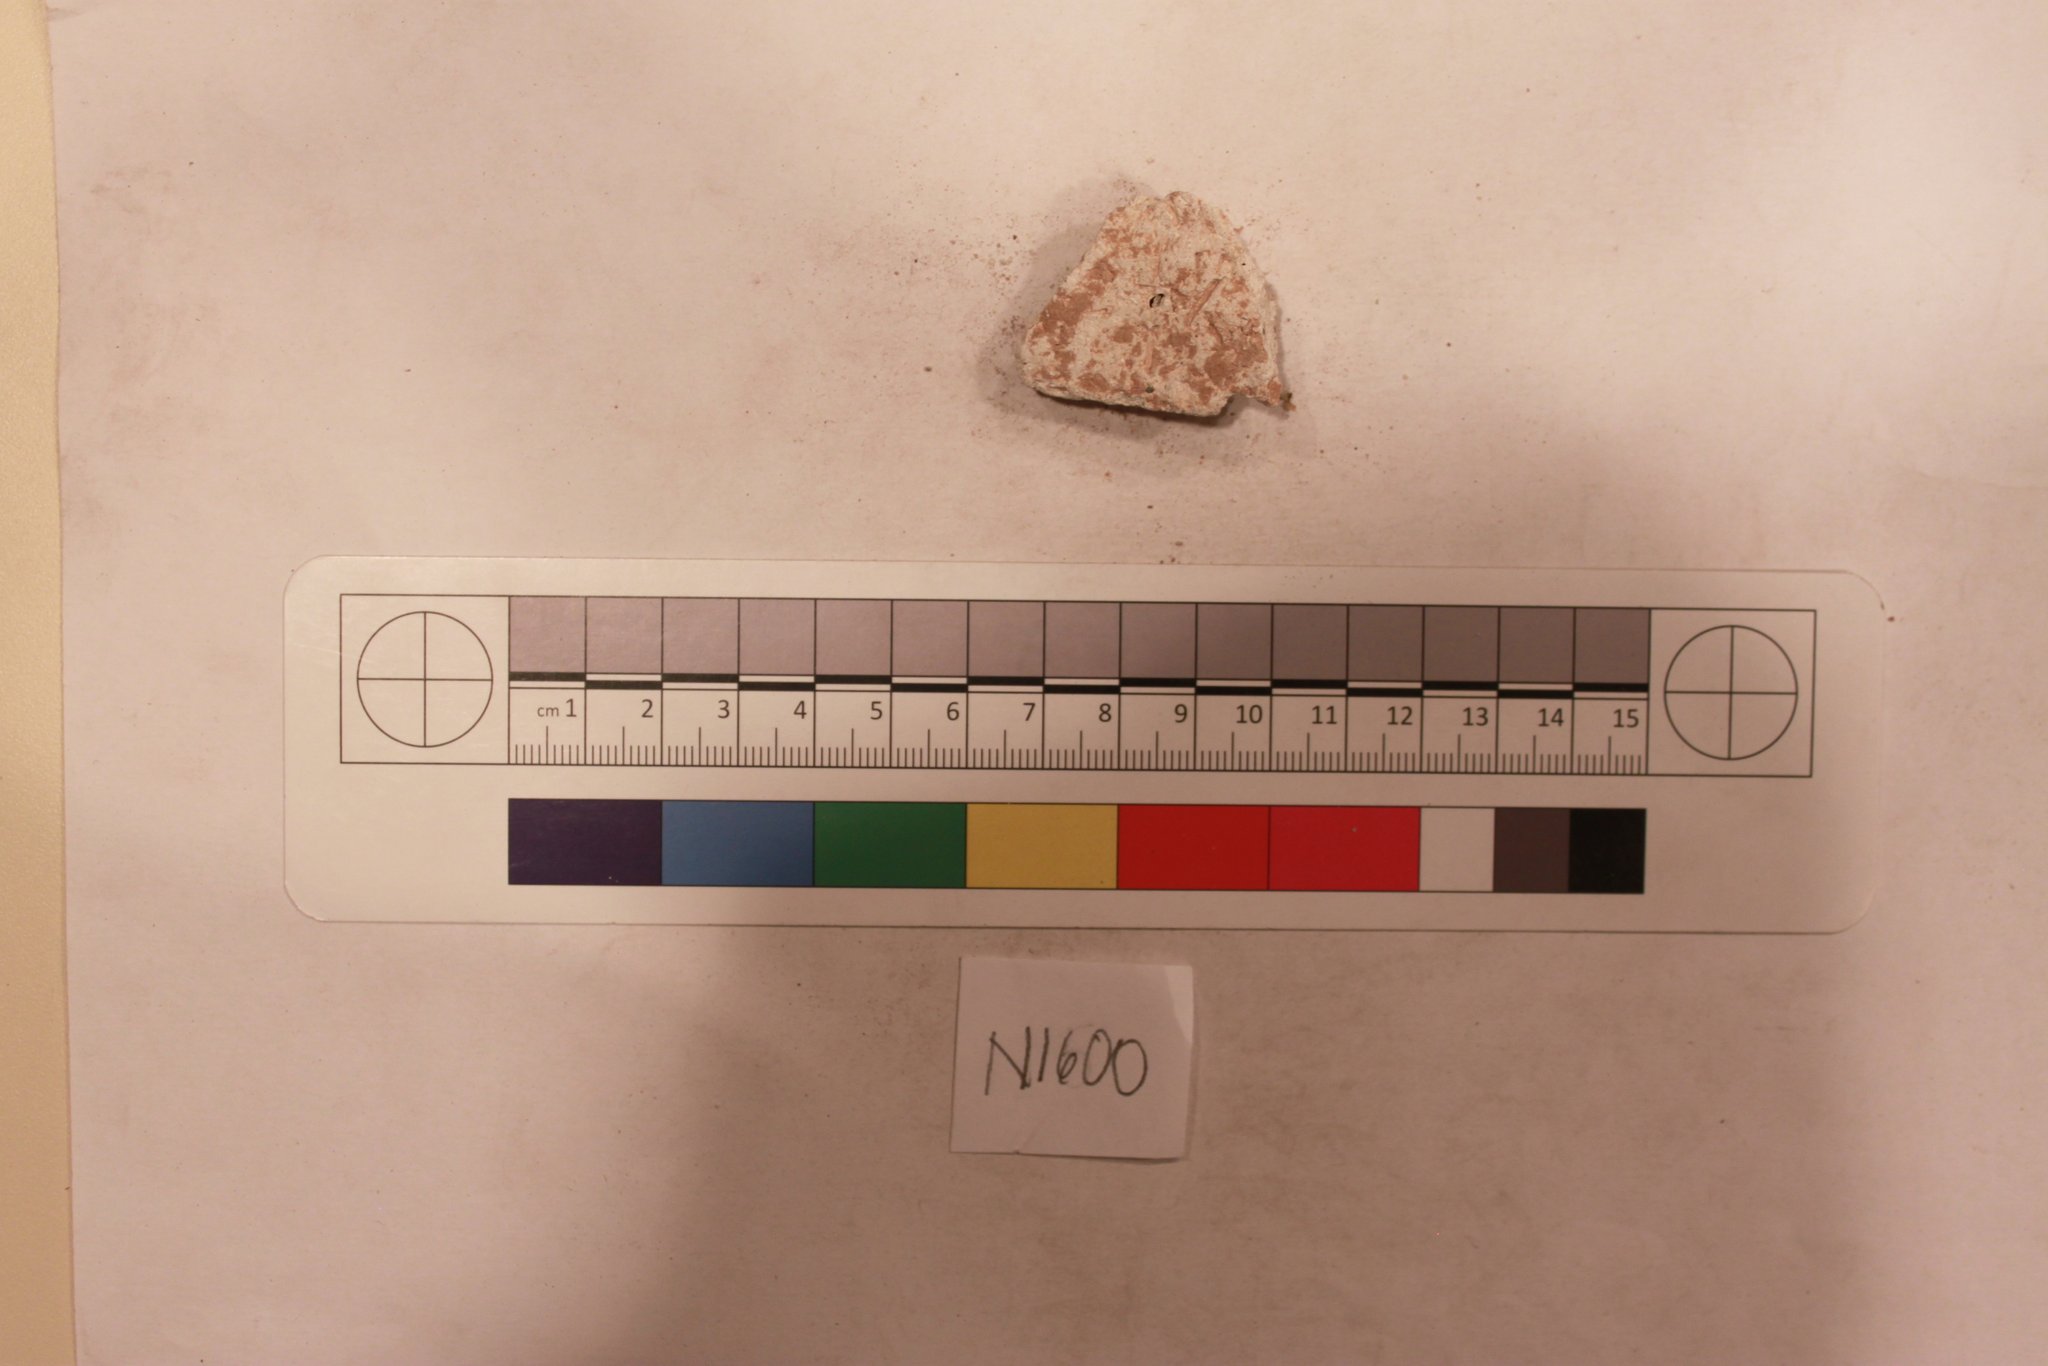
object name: fragment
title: Stucco Fragment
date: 701-1200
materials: plaster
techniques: carving, painting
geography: iran